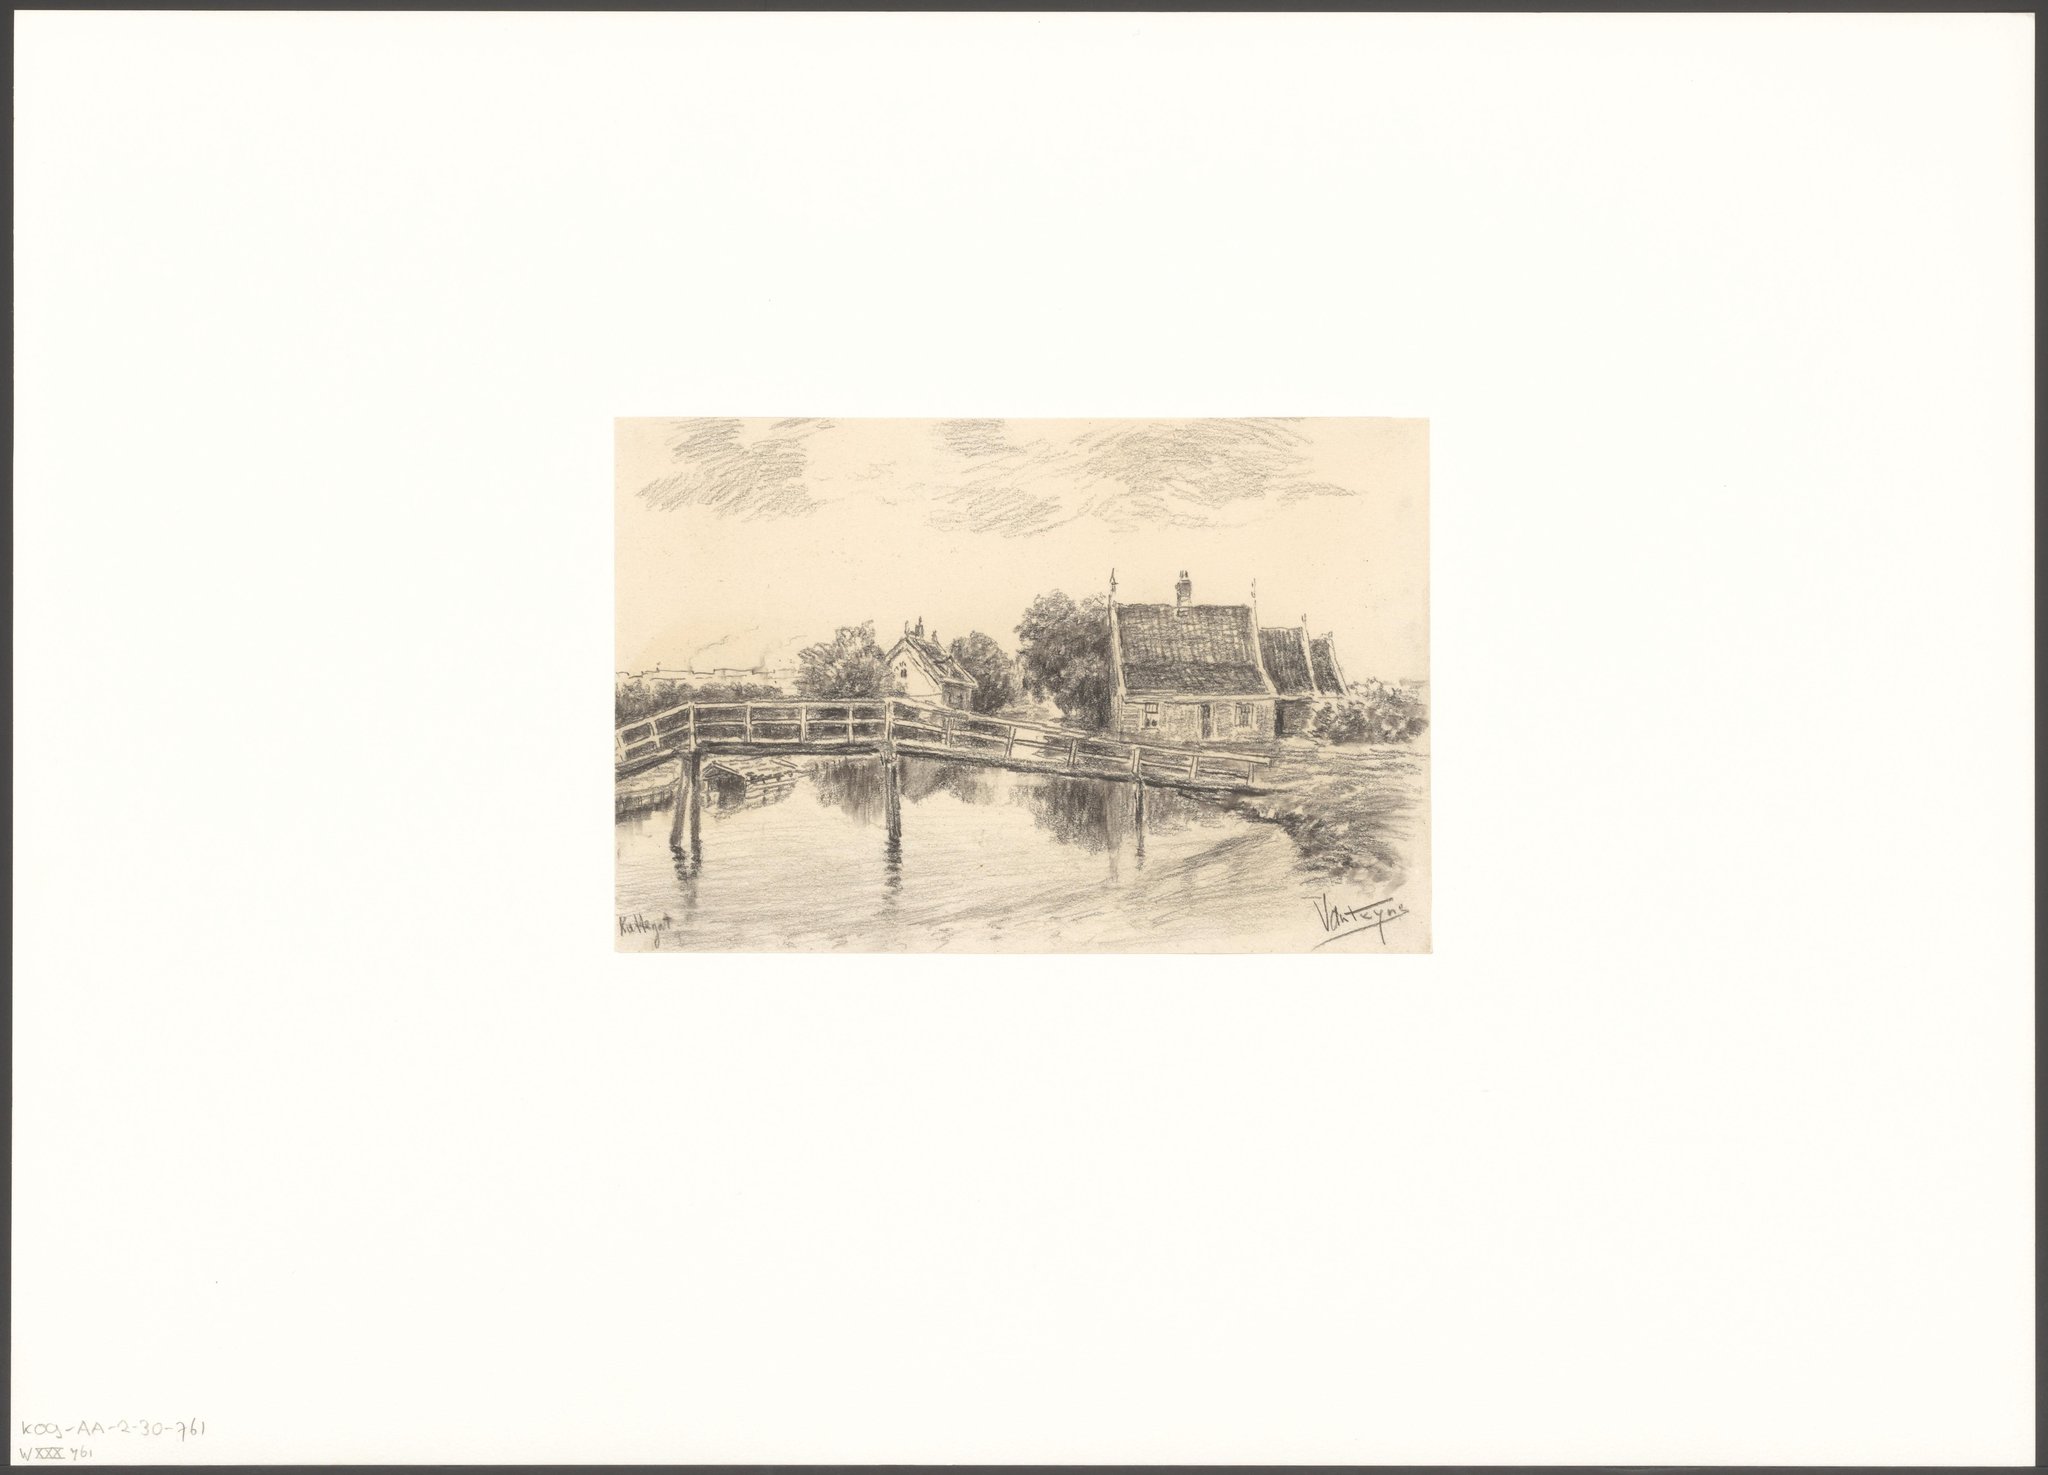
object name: drawing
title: Gezicht op het Kattengat naar de Kostverlorenvaart bij de Hoofdweg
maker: anthonie van teijn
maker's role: draughtsman, painter, print maker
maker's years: 1863-1943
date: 1910-1927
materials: chalk, paper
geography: amsterdam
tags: city-view in general; 'veduta', canal, bridge in city across river, canal, etc.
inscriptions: collector's mark: Lugt 800a, inscription: ‘Kattegat’, signature: ‘VanTeyne’, inscription: ‘Het Kattegat gezien (...) Oct 1927. / vanEck’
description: Tekening binnen de Atlas Van Eck ingedeeld op wijknummer 30.